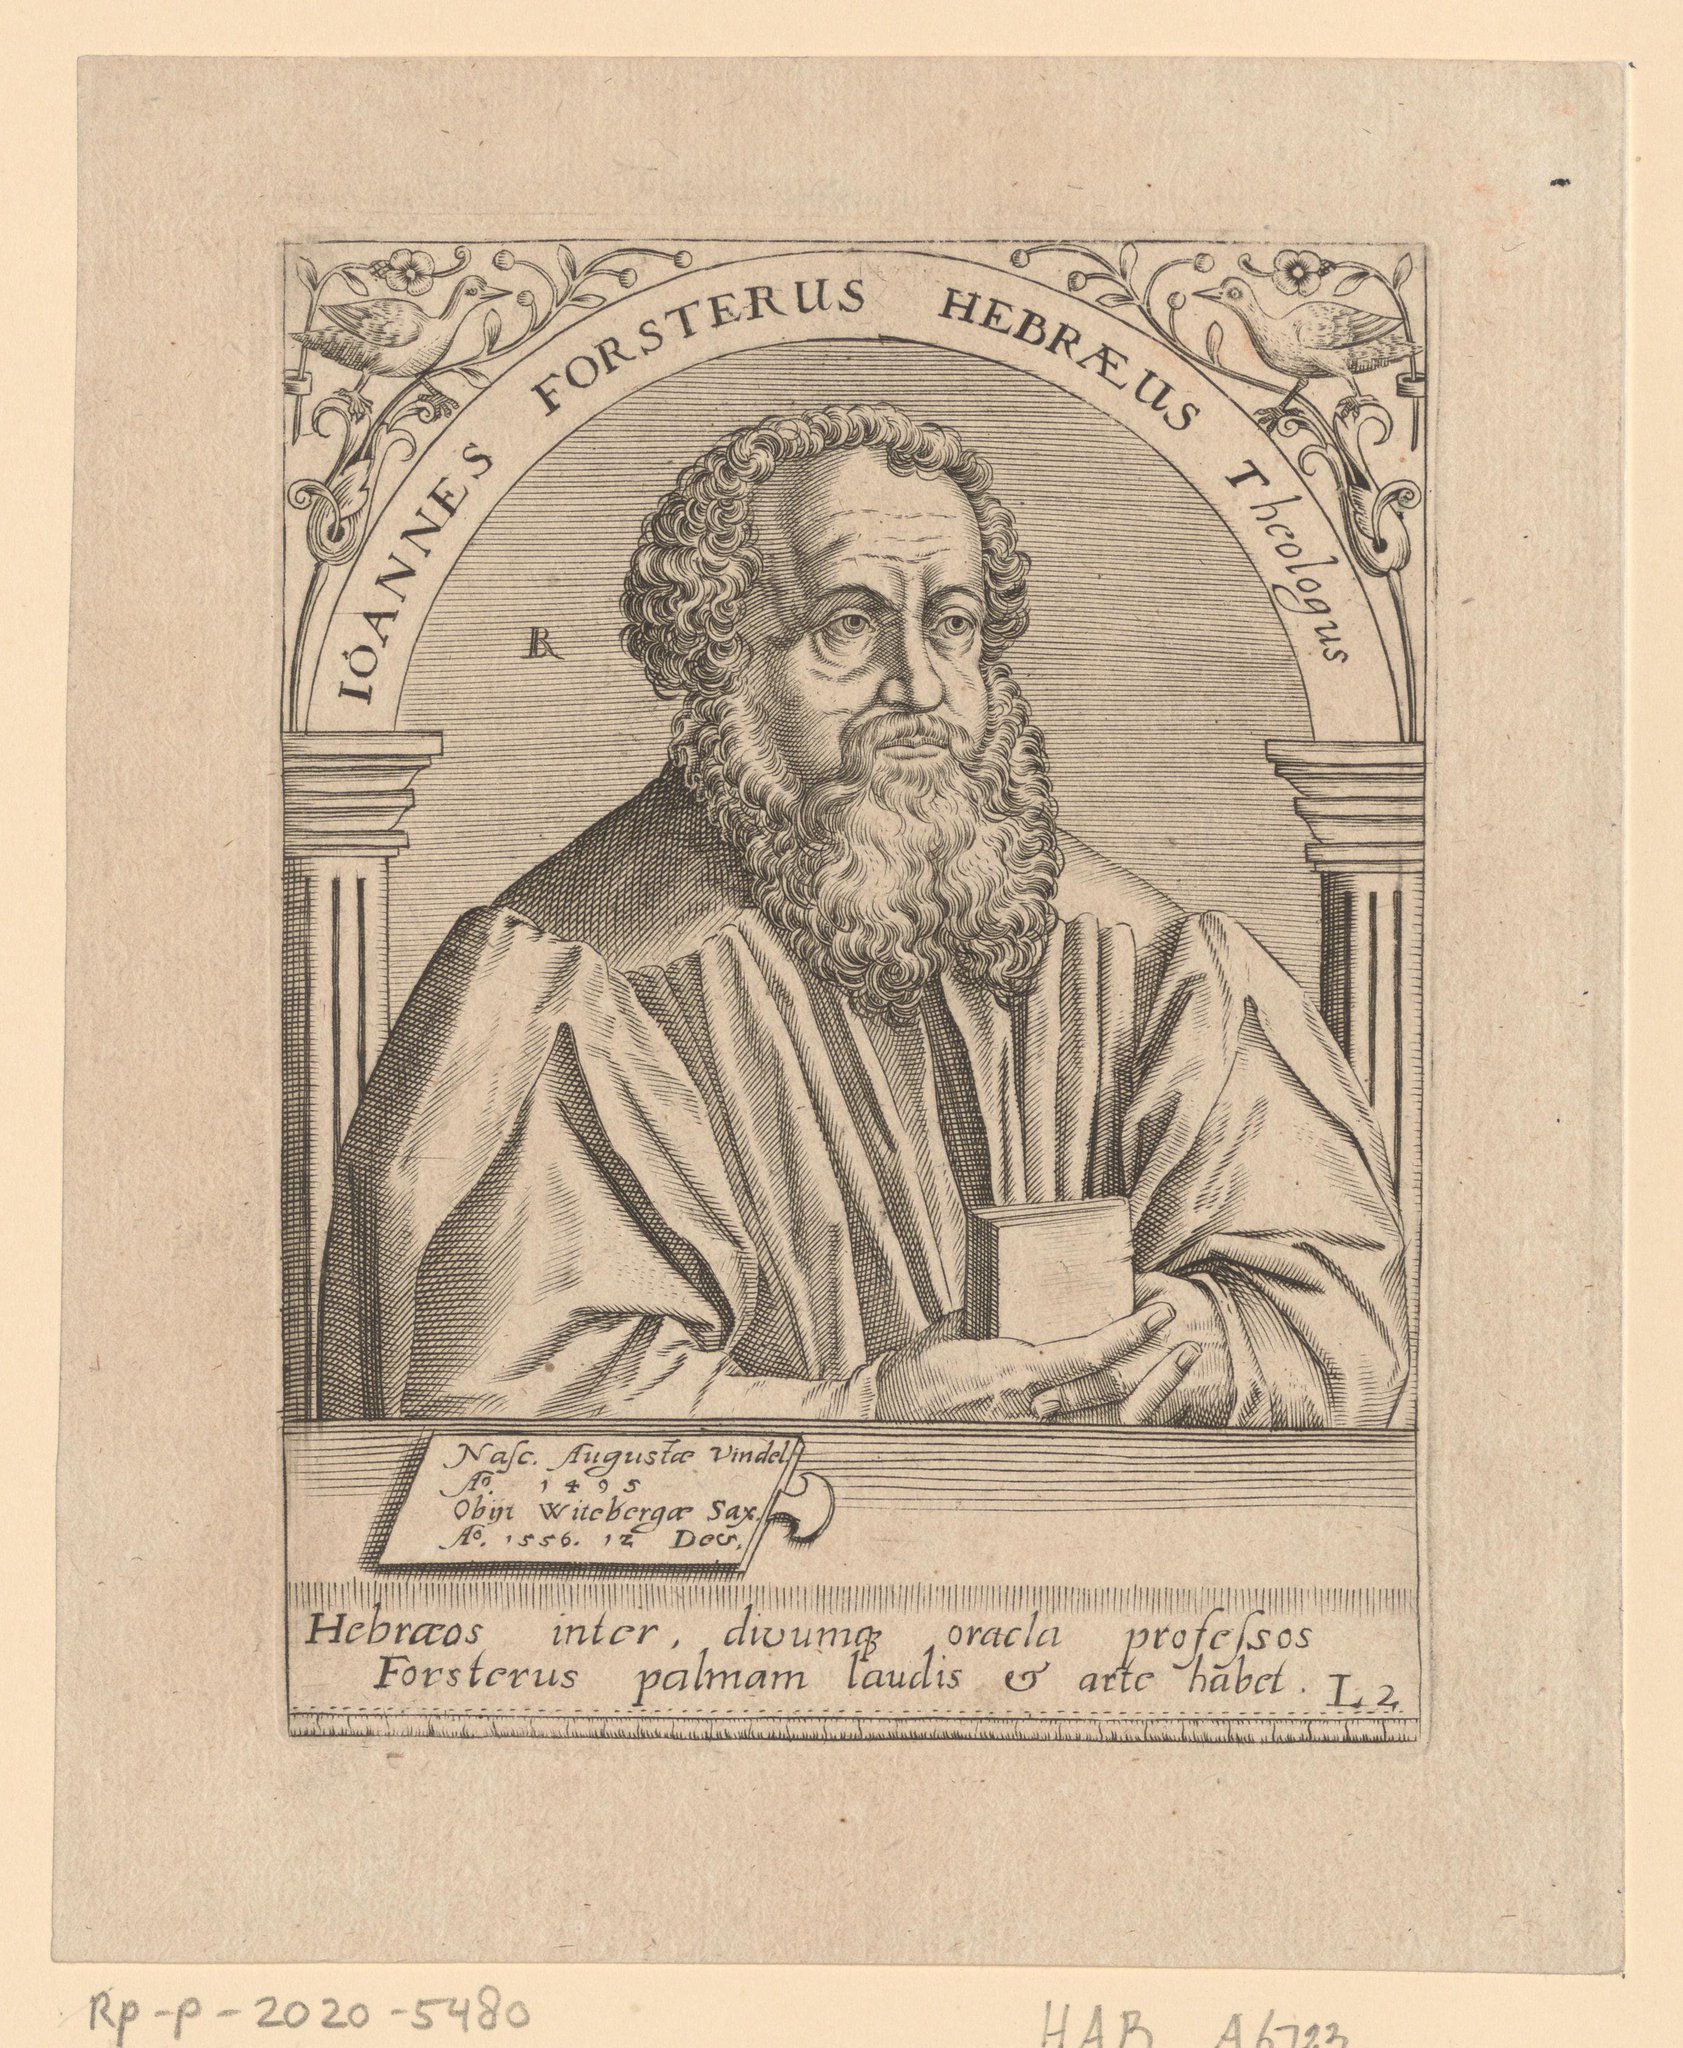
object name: print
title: Portret van Johann Forster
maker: robert boissard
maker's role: print maker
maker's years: 1570-1611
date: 1597-1599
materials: paper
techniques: engraving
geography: france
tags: augsburg, theologian, historical persons, book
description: Met tweeregelig onderschrift in het Latijn. Rechtsonder genummerd: L2.